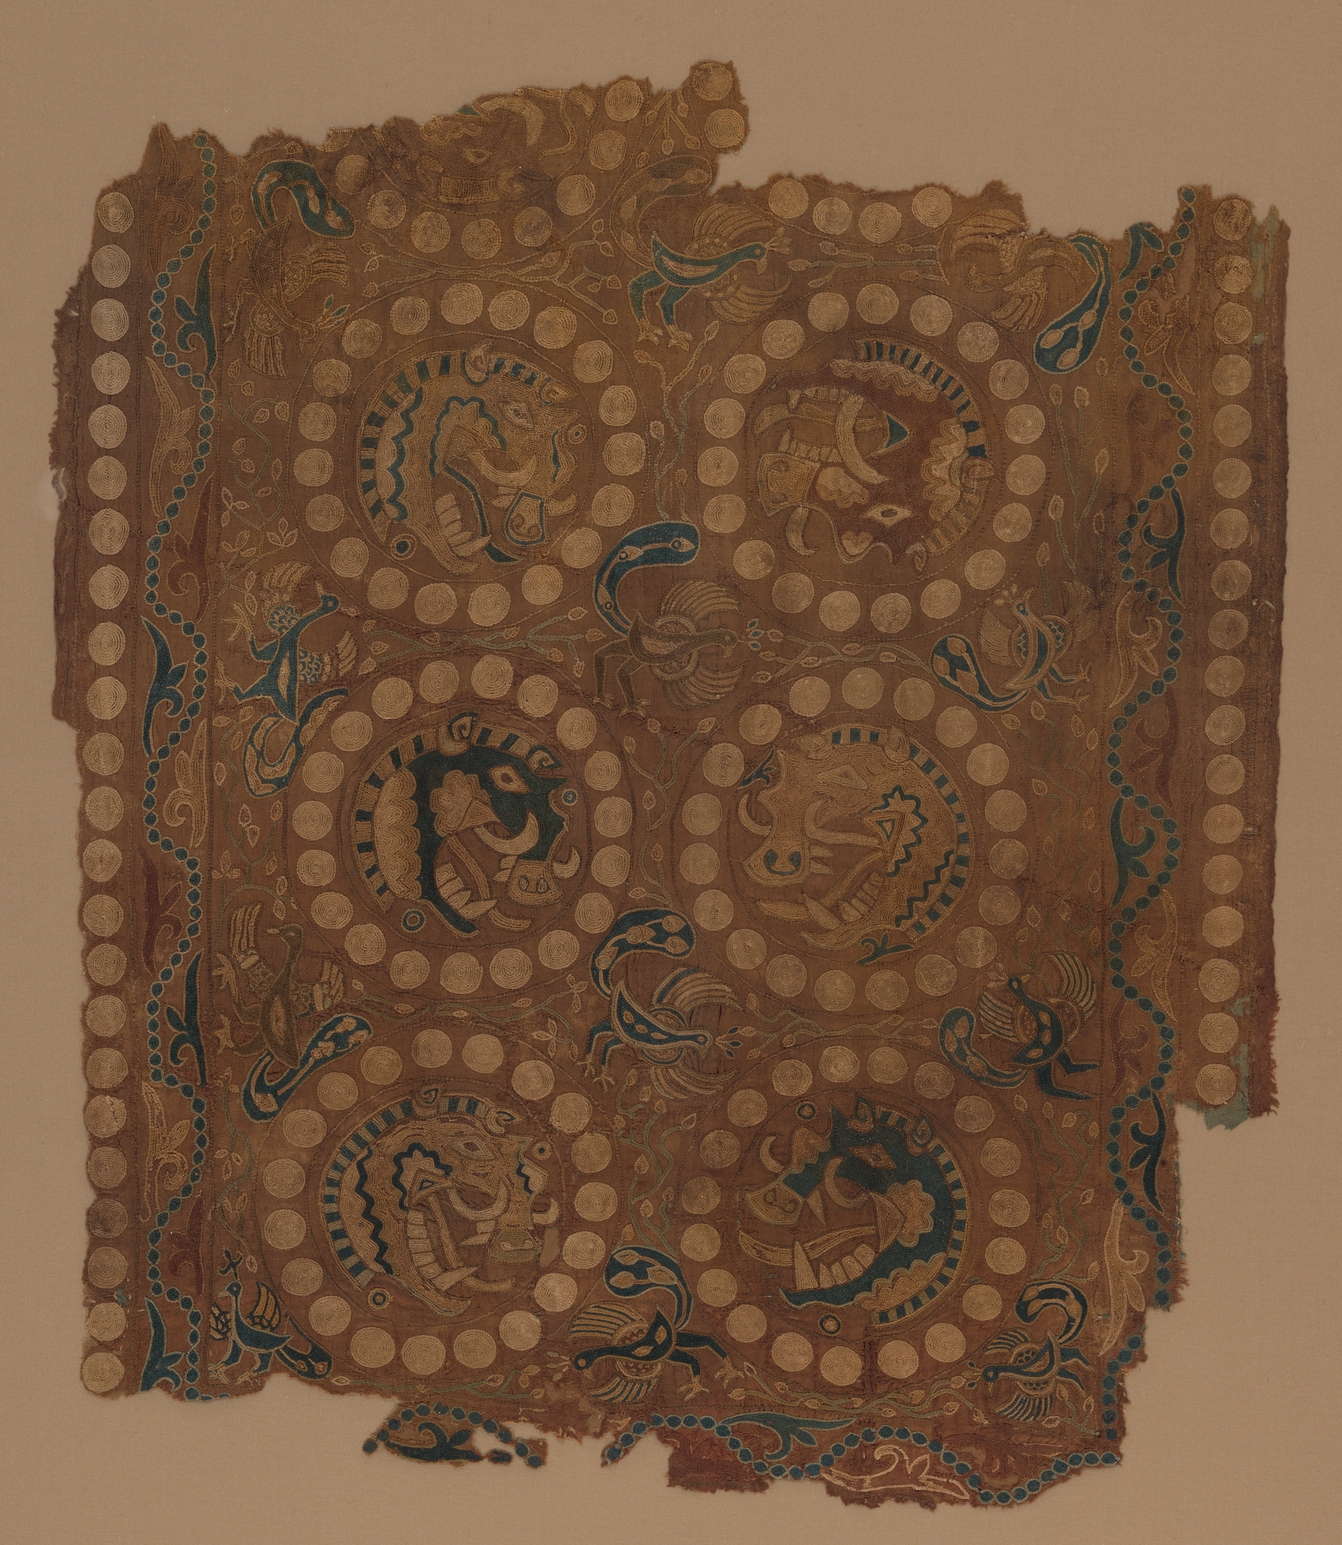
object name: panel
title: Textile with Boar's Head Roundels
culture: iranian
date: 601-700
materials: silk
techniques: embroidery, weave, stitching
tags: peacocks,boars